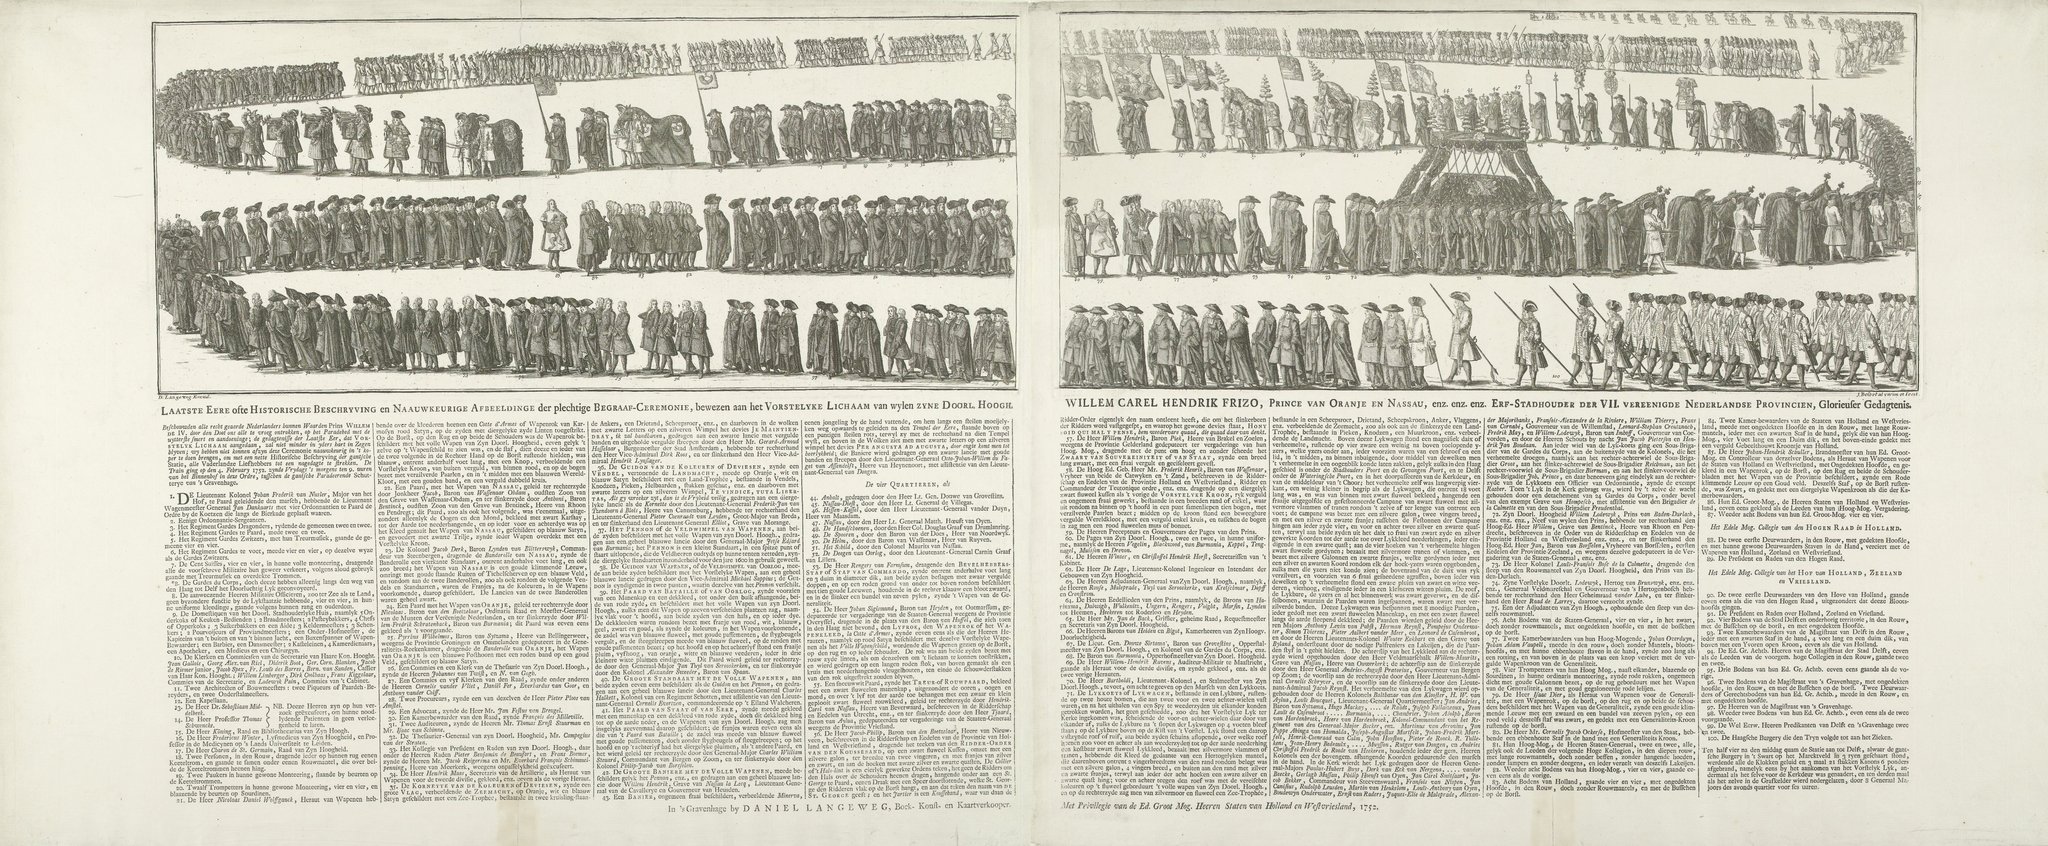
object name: print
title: Laatste Eere ofte Historische Beschryving en Naauwkeurige Afbeeldinge der plechtige Begraaf-Ceremonie, bewezen aan het Vorstelyke Lichaam van wylen Doorl. Hoogh. Willem Carel Hendrik Frizo, Prince van Oranje en Nassau, enz. enz. enz. Erf-Stadhouder der VII. Vereenigde Nederlandse Provincien, Glorieuser Gedagtenis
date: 1752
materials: paper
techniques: etching, letterpress printing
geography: northern netherlands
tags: willem iv (prins van oranje-nassau), cortege, funeral procession, delft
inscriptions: collector's mark: Lugt 2228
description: De rouwstoet met de lijkwagen en doodskist van stadhouder Willem IV, begrafenis te Delft op 4 februari 1752. Grote voorstelling gedrukt op twee bladen. Op het blad onder de plaat in de legenda de uitgebreide verklaring van de cijfers 1-56.